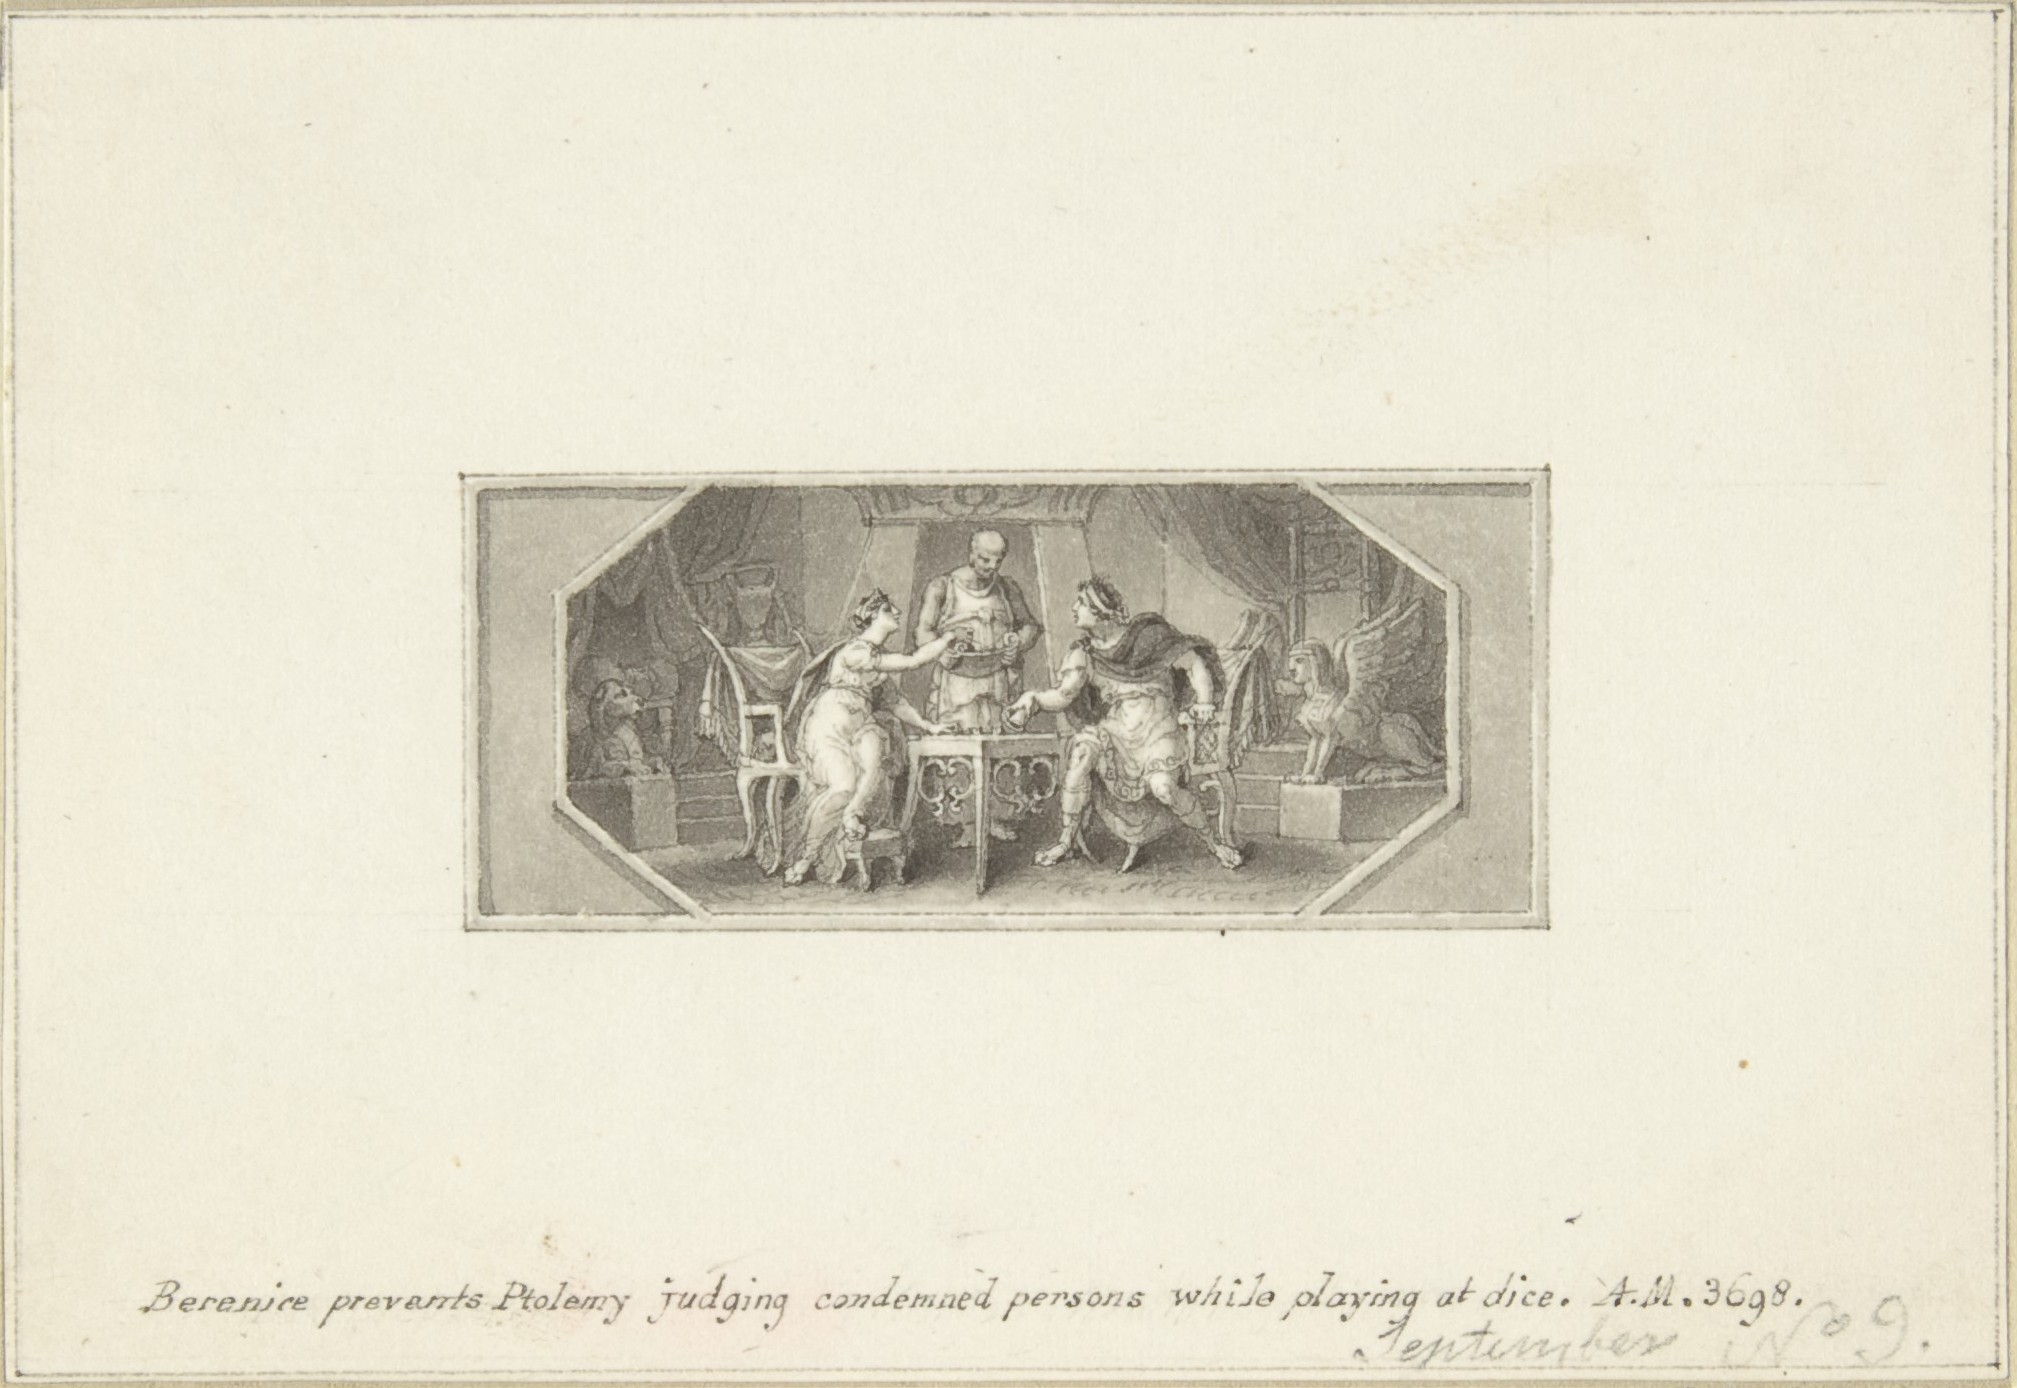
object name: drawing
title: Berenice prevents Ptolemy judging Condemned Persons while playing at Dice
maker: edward francis burney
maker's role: artist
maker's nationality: british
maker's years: 1760-1848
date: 1790-1800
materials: ink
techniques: brush, pen, wash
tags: men,women,playing